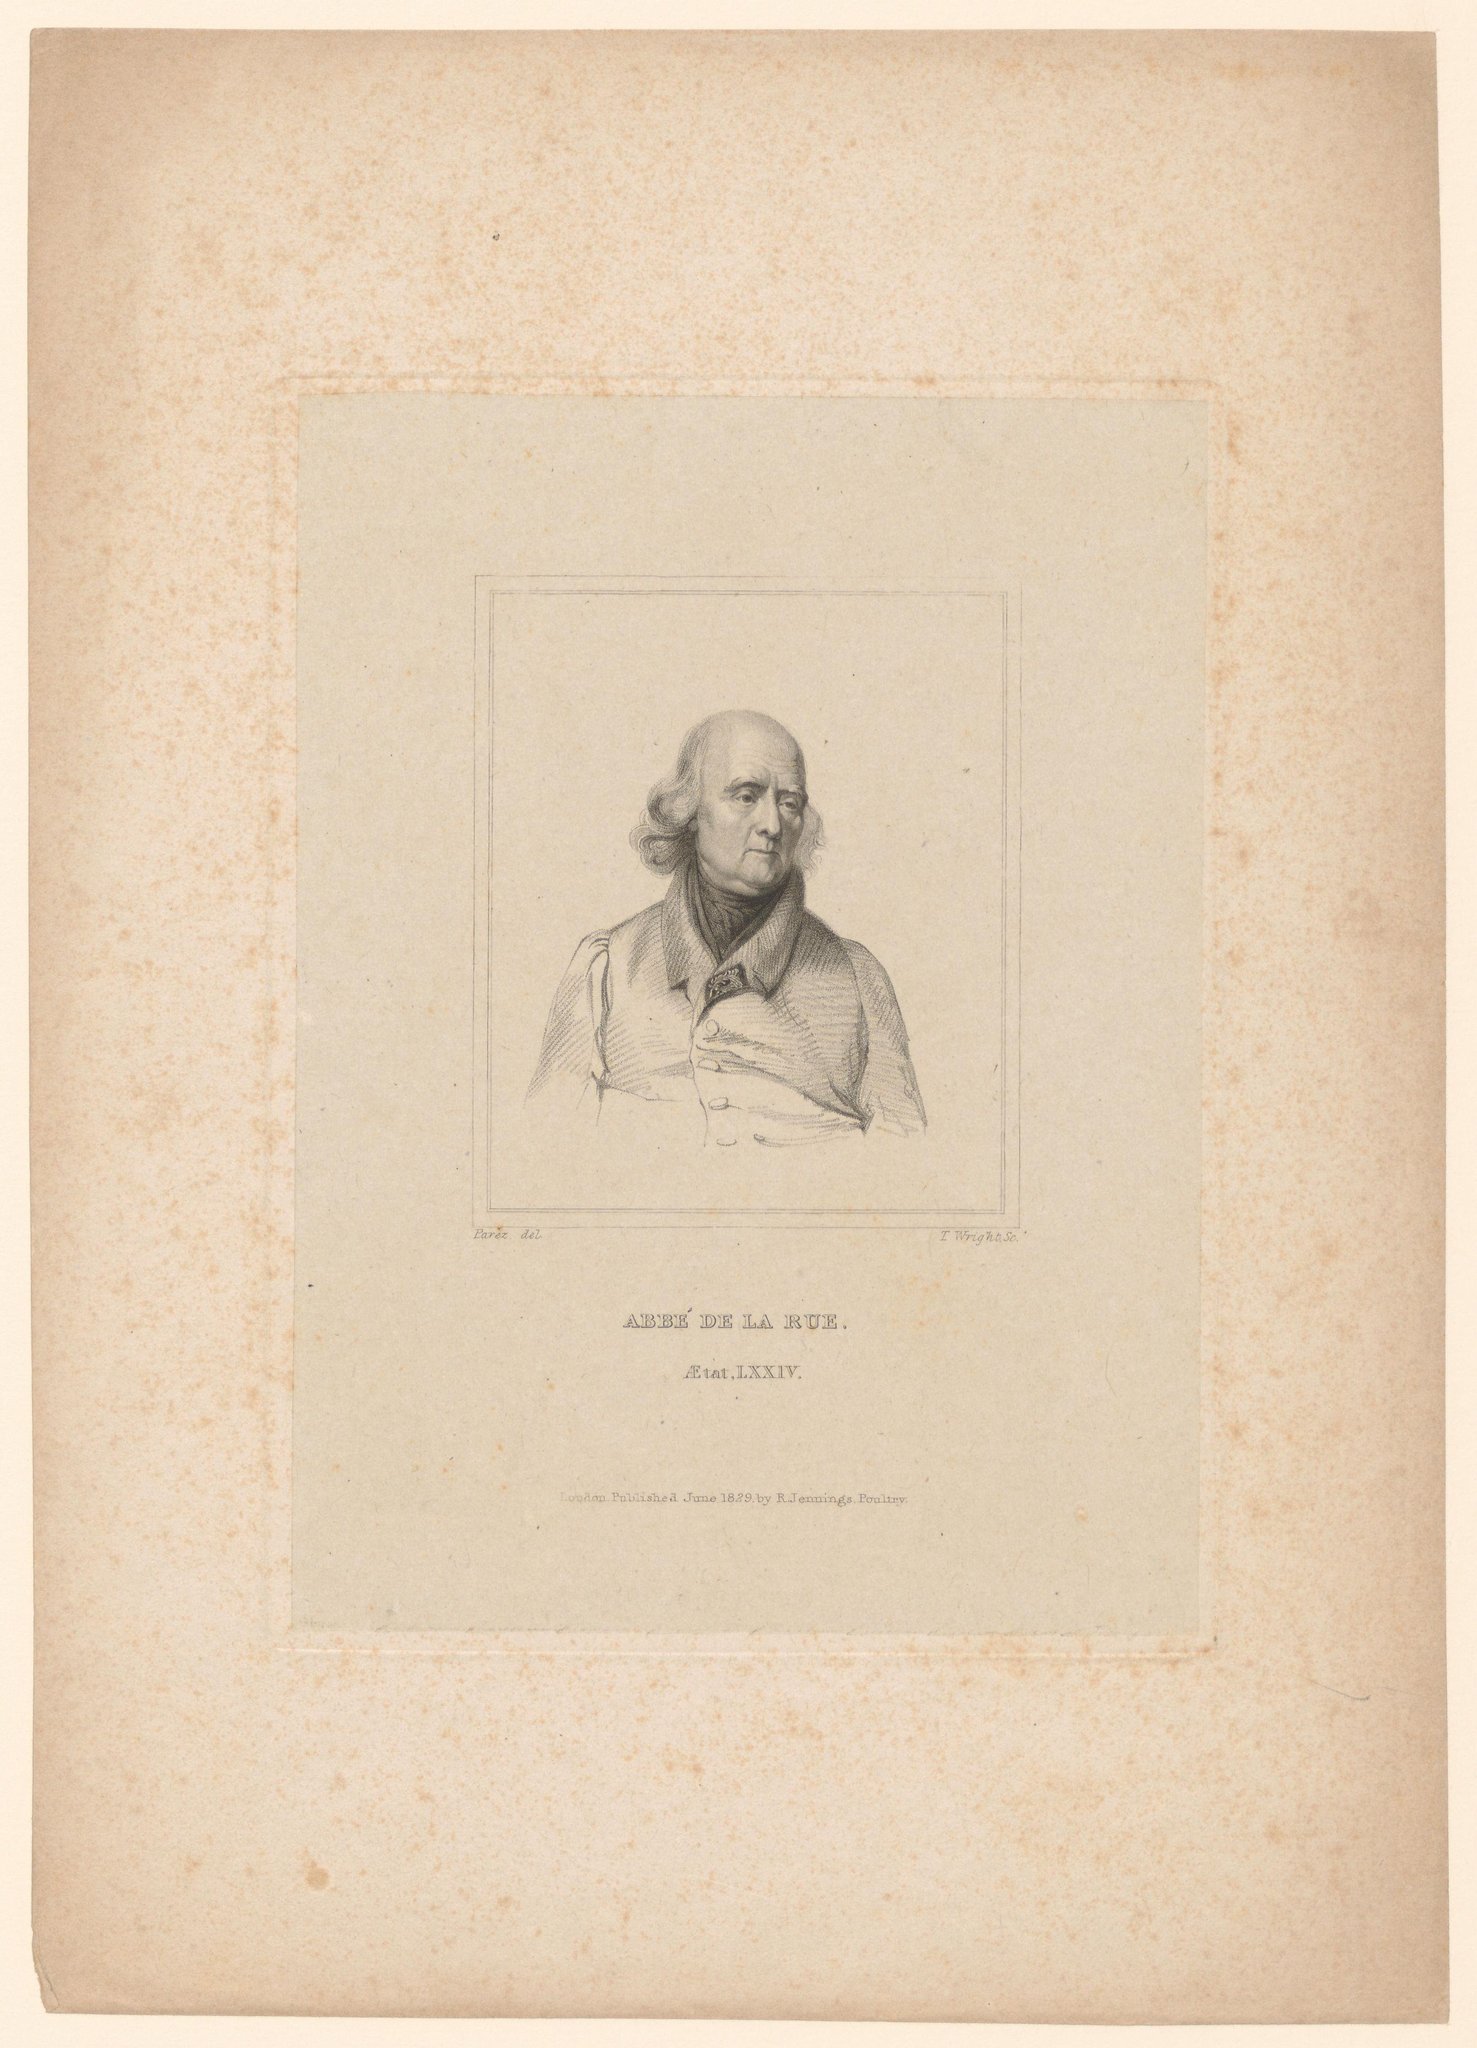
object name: print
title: Abbé de la Rue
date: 1829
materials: paper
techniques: etching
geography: london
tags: historical persons, portrait of a writer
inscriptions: collector's mark: Lugt 2228